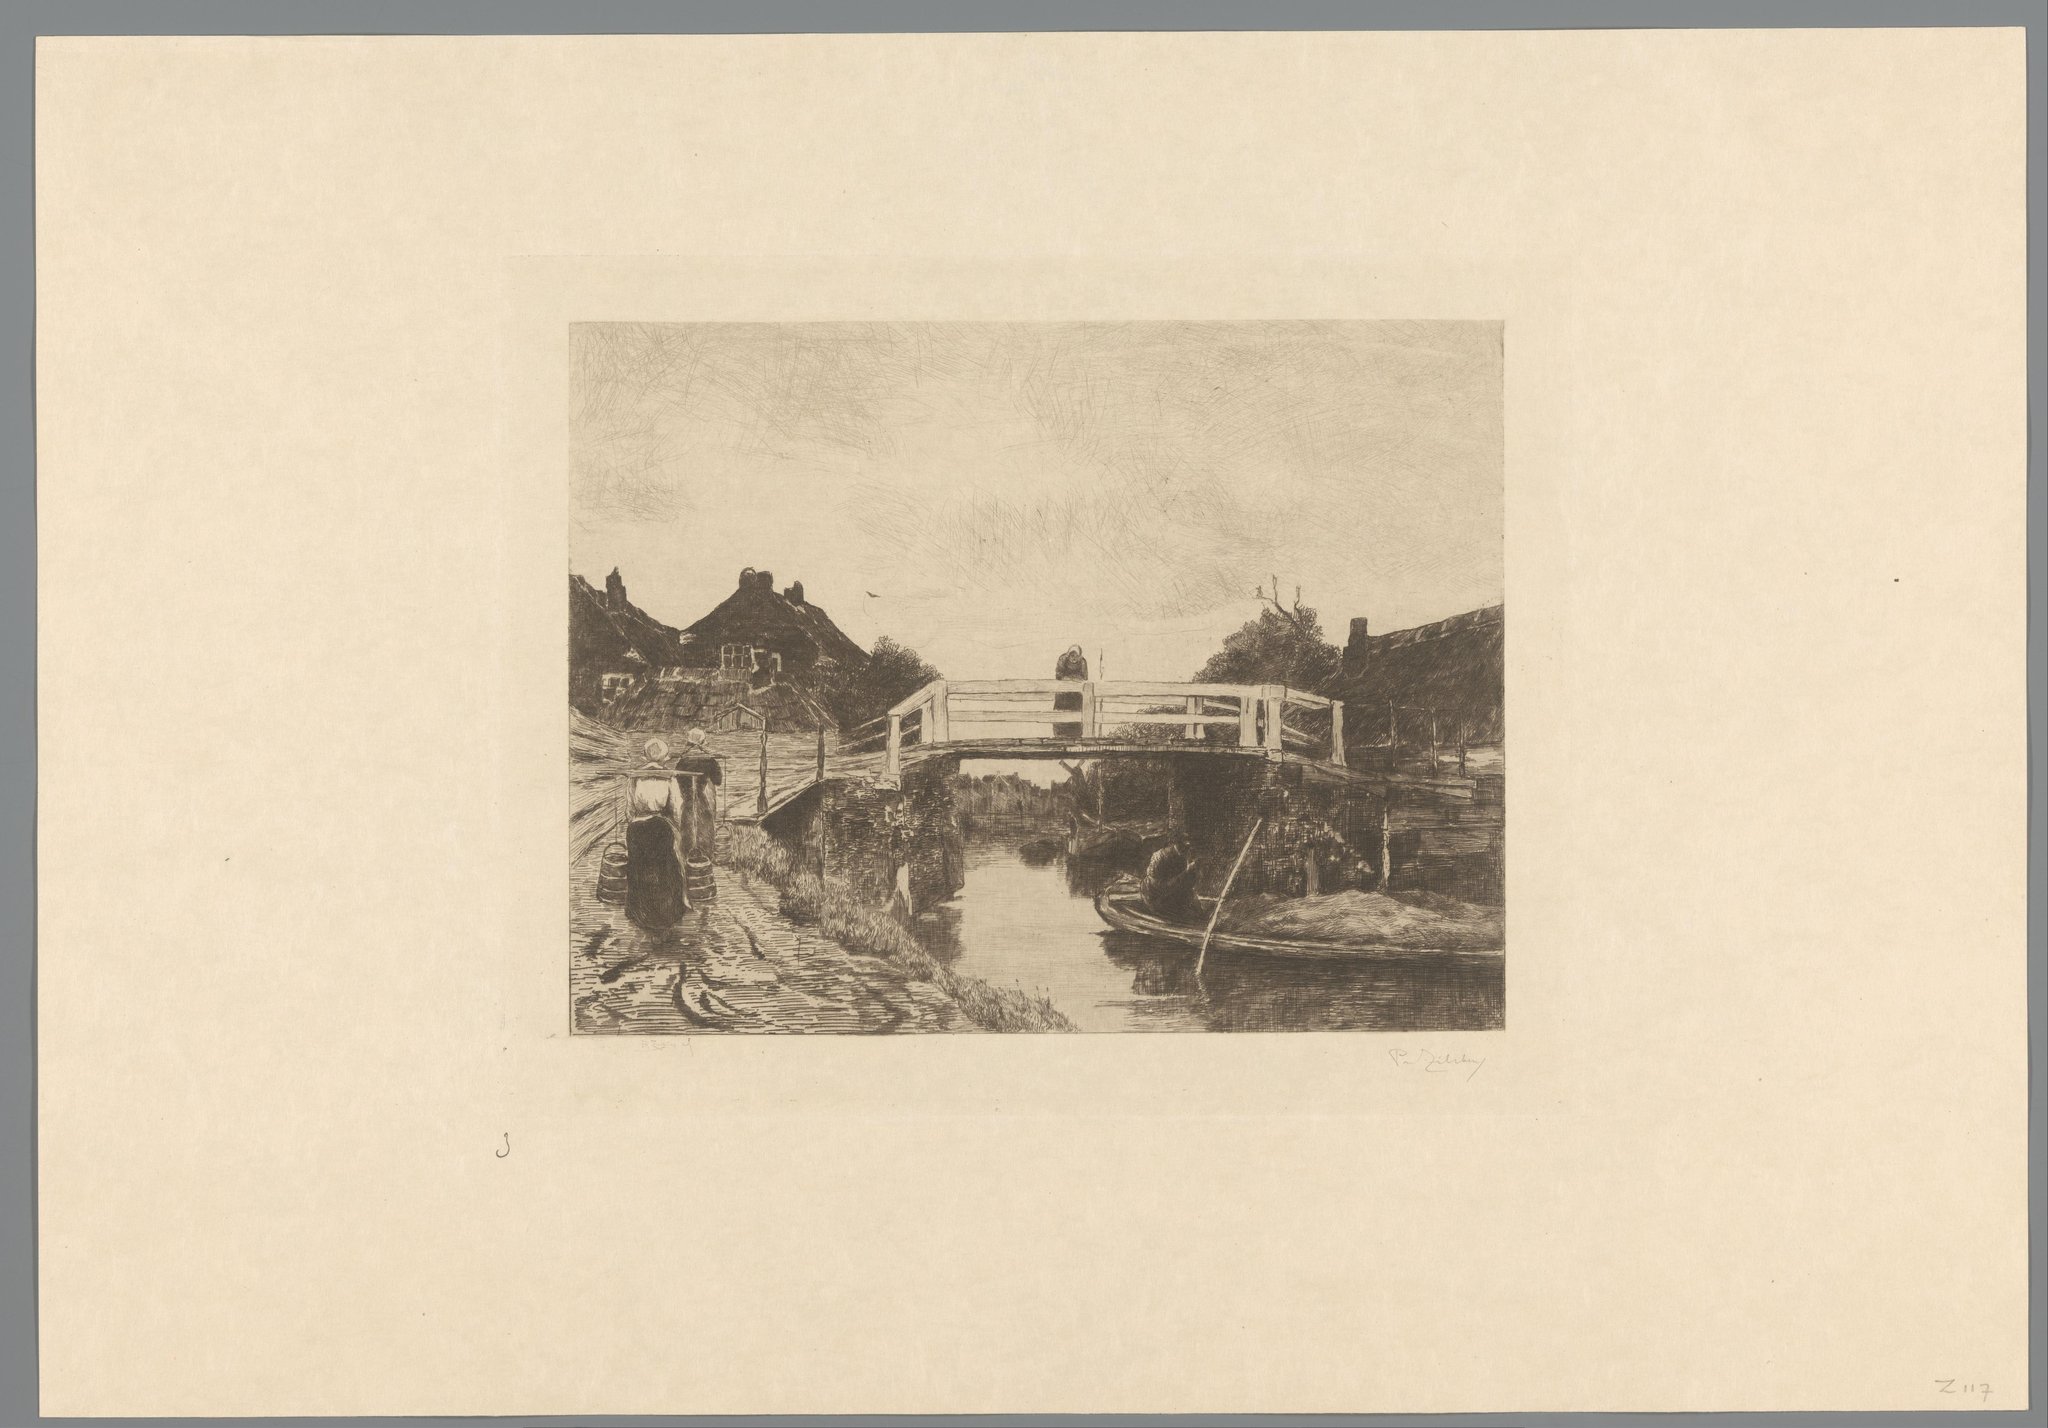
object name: print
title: Brug over een vaart in een dorp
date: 1888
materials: paper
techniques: drypoint, etching, intaglio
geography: amsterdam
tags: village, bridge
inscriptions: collector's mark: Lugt 2228, number: ‘3’